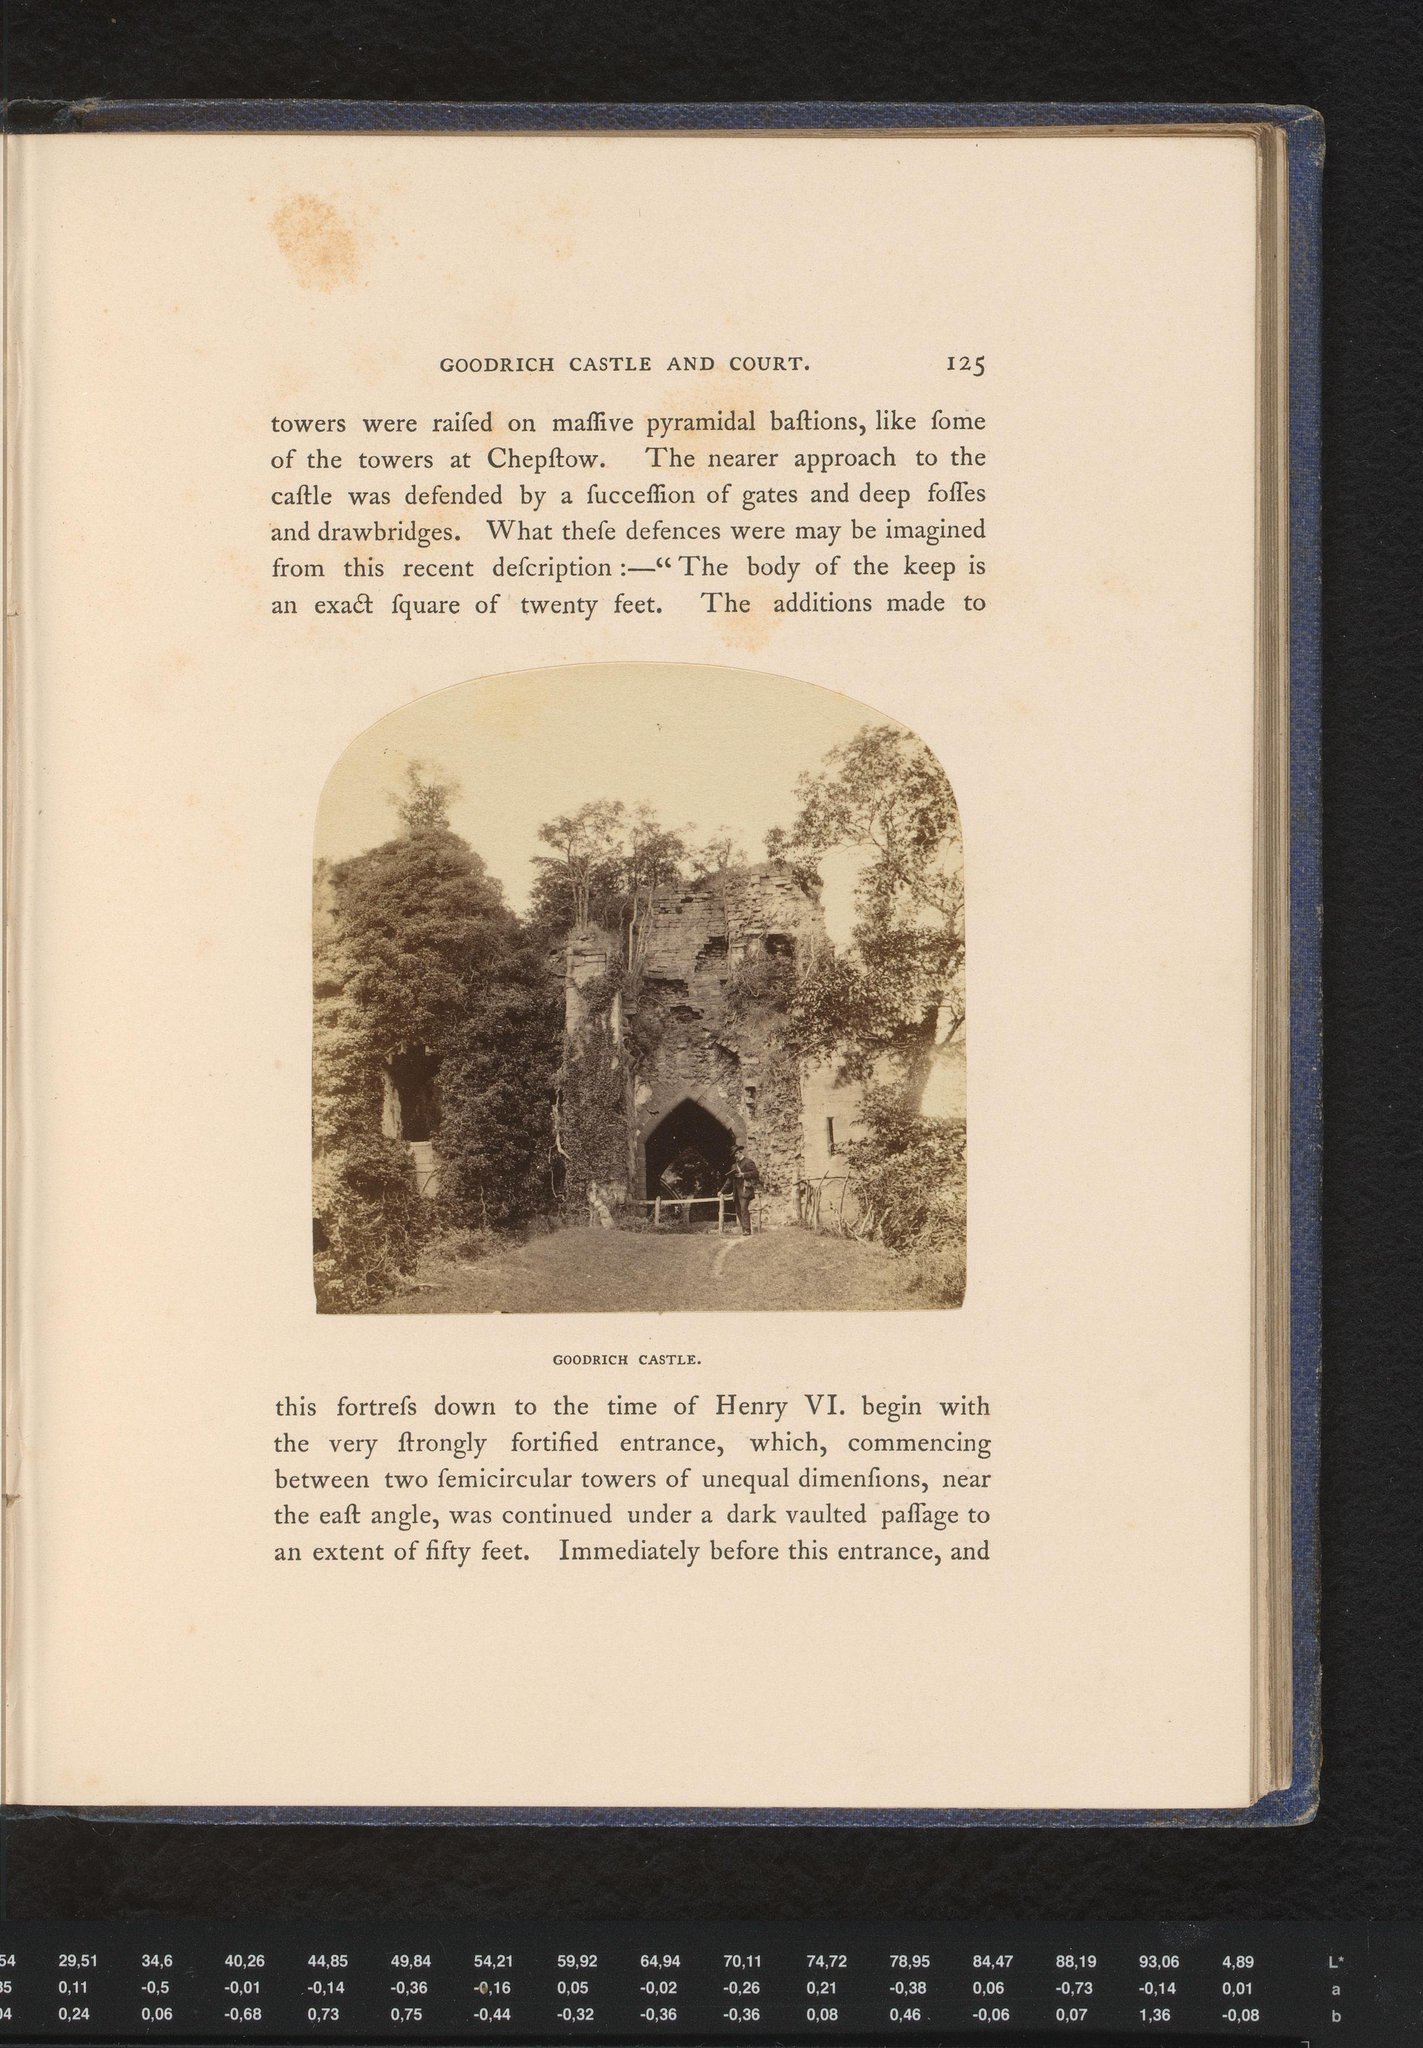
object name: photograph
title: Ruïne van Goodrich Castle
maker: francis bedford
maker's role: print maker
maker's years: 1815-1894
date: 1857-1862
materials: paper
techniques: albumen print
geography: goodrich castle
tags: ruin of a dwelling, house, castle, etc.